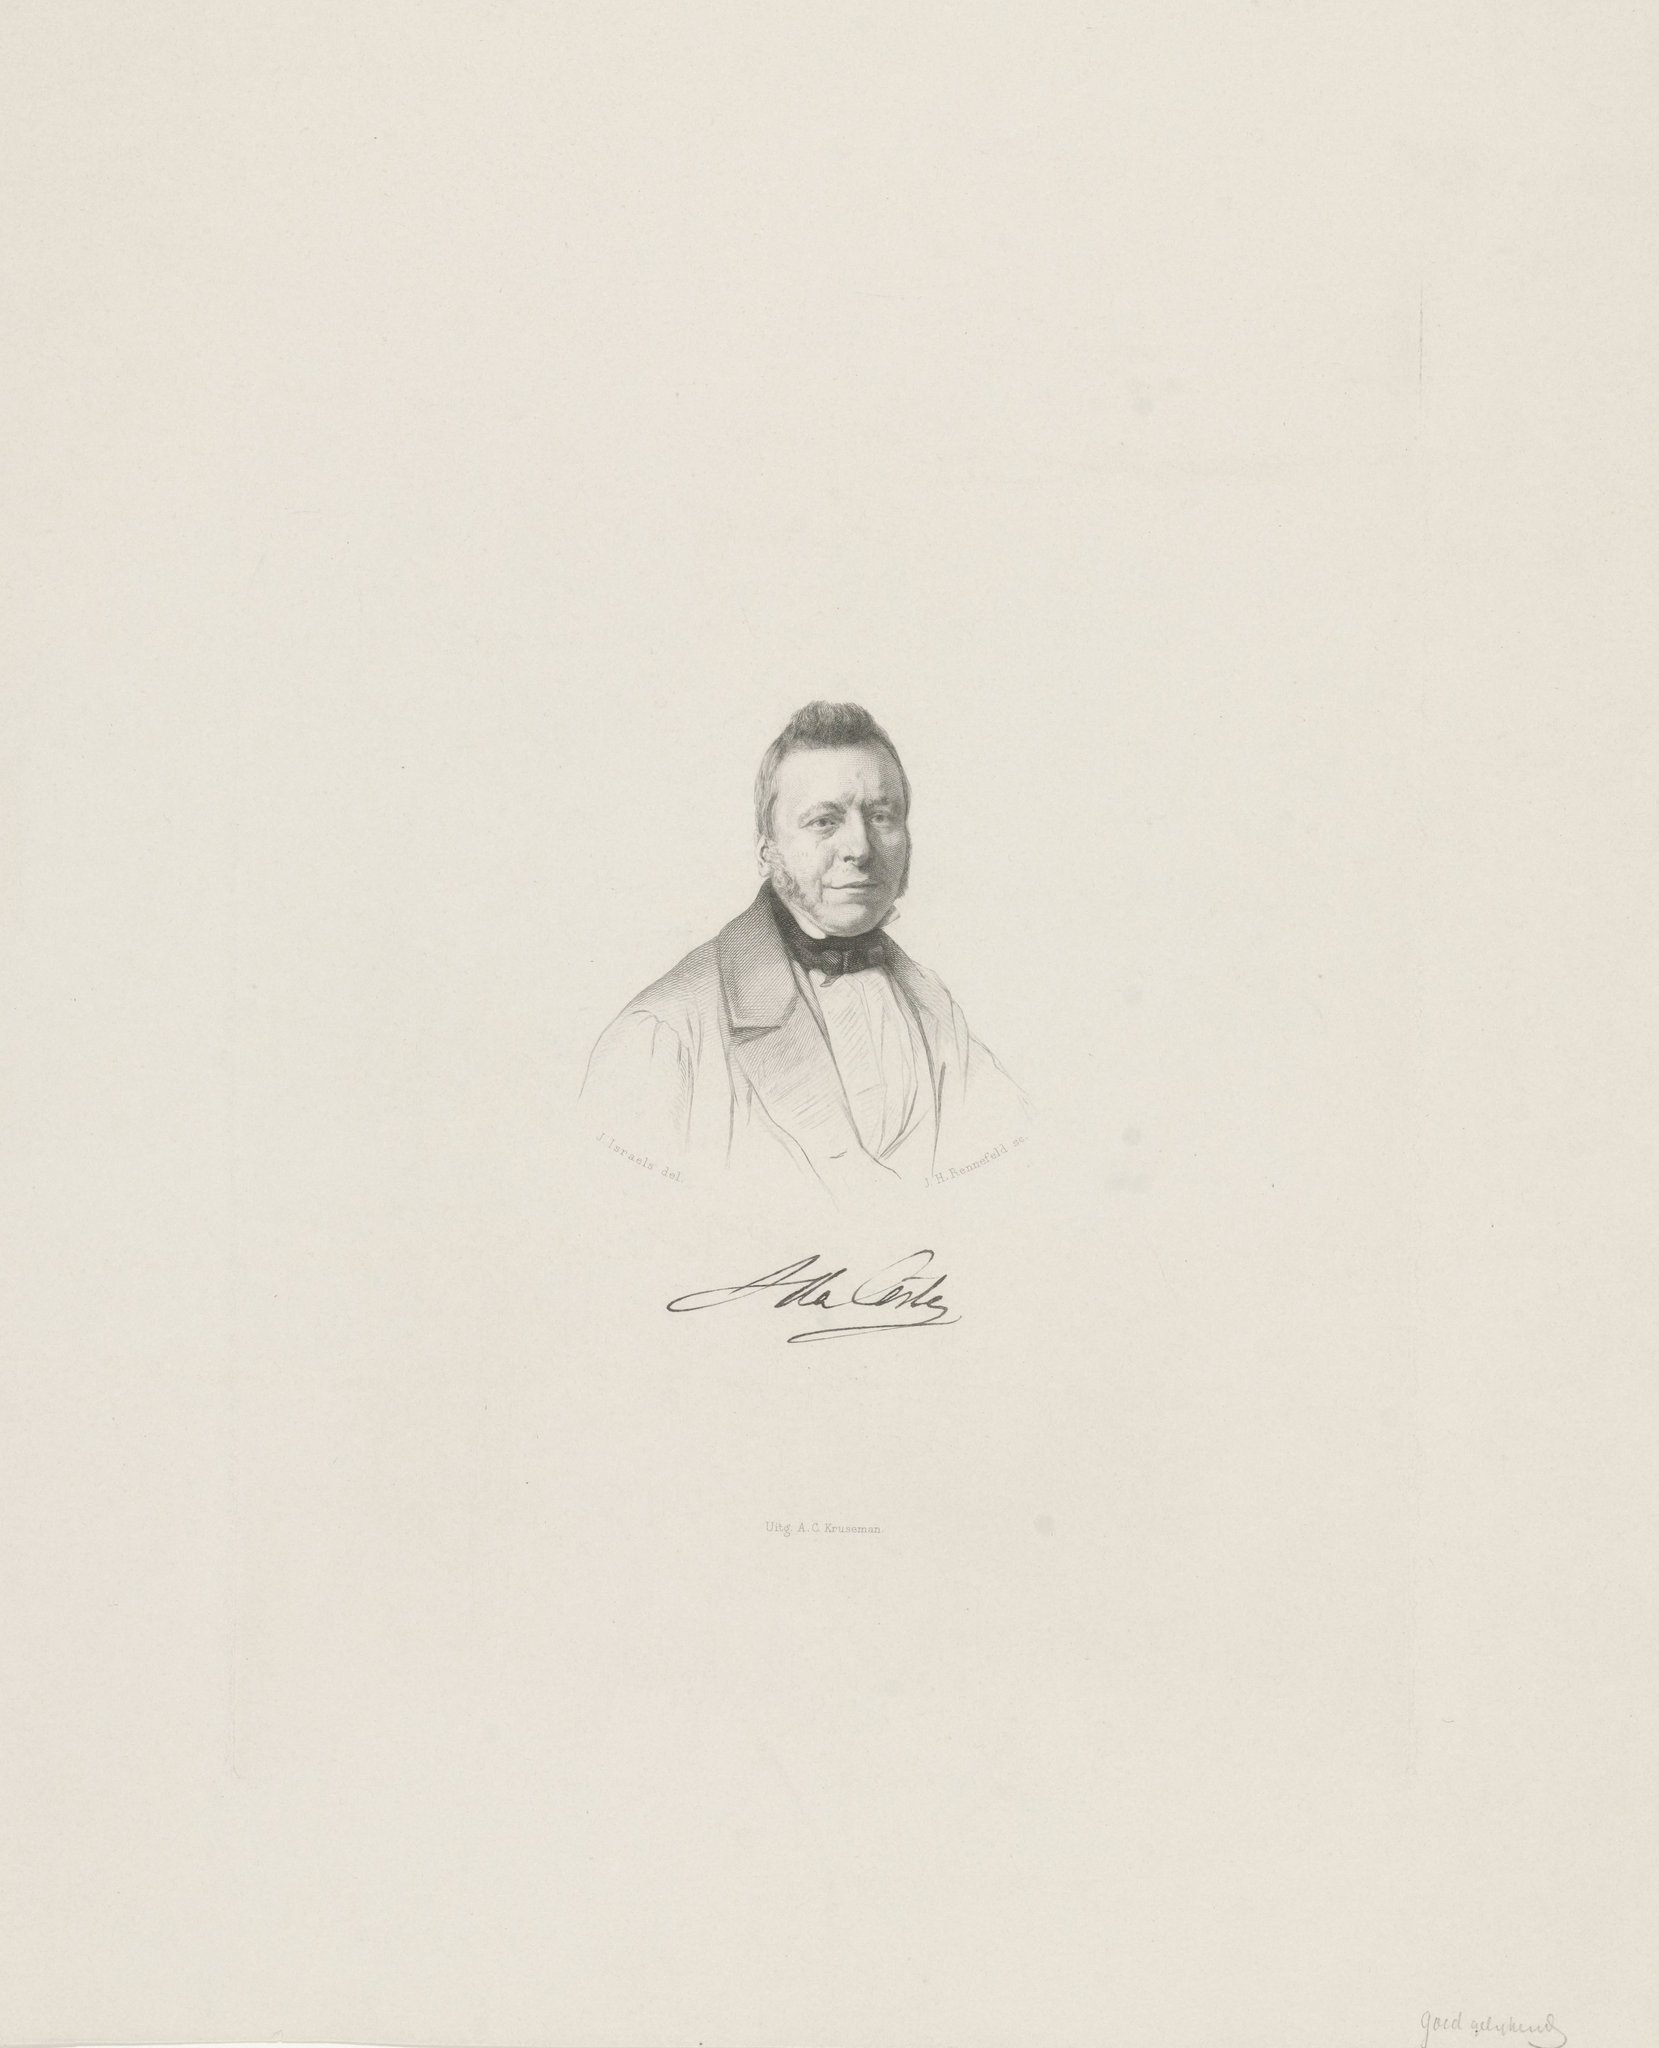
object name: print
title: Portret van Isaac Da Costa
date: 1845-1877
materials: paper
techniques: roulette, engraving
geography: amsterdam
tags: amsterdam, isaac da costa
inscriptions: inscription: ‘Goed gelijkend’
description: Portret van Isaac Da Costa, dichter en rechtsgeleerde.